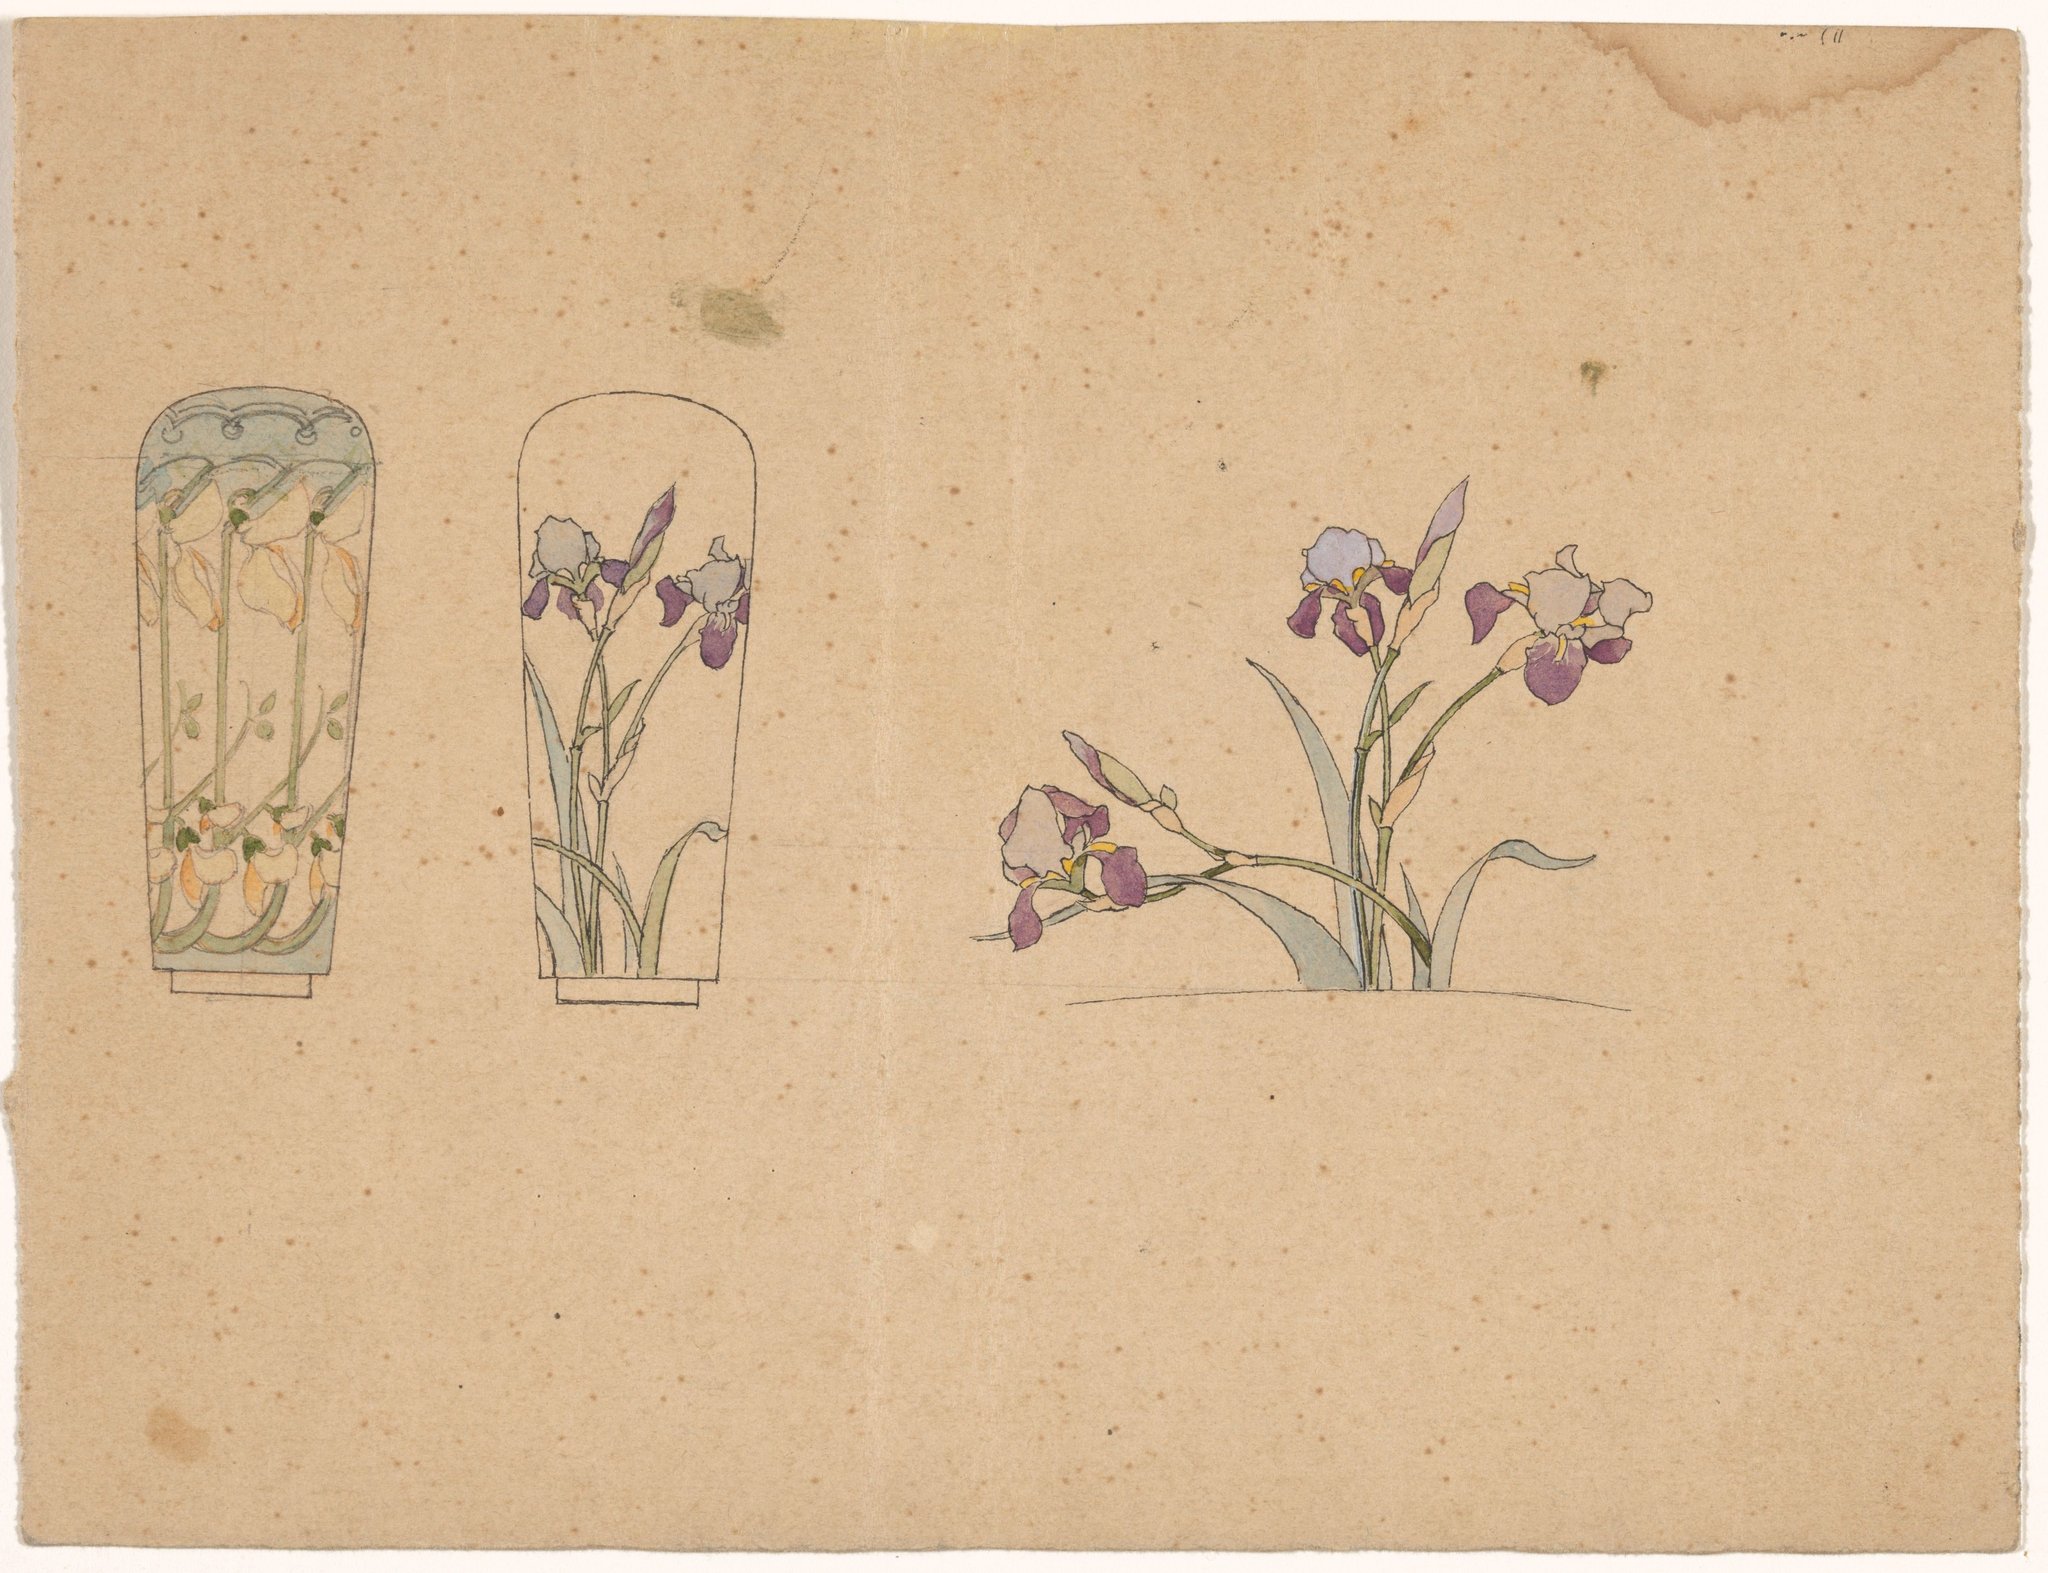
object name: design drawing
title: Designs for the Decoration of Two Vases and Two Handles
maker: anatole-alexis fournier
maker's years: 1864-1926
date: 1897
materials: ink, paper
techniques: pen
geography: sèvres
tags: flowers: iris, flowers ~ ornament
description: These small drawings demonstrate how the artist adapted a repeating or a single, asymmetrical pattern to the shape to be painted. The designs were probably made for the Sèvres porcelain manufactory.